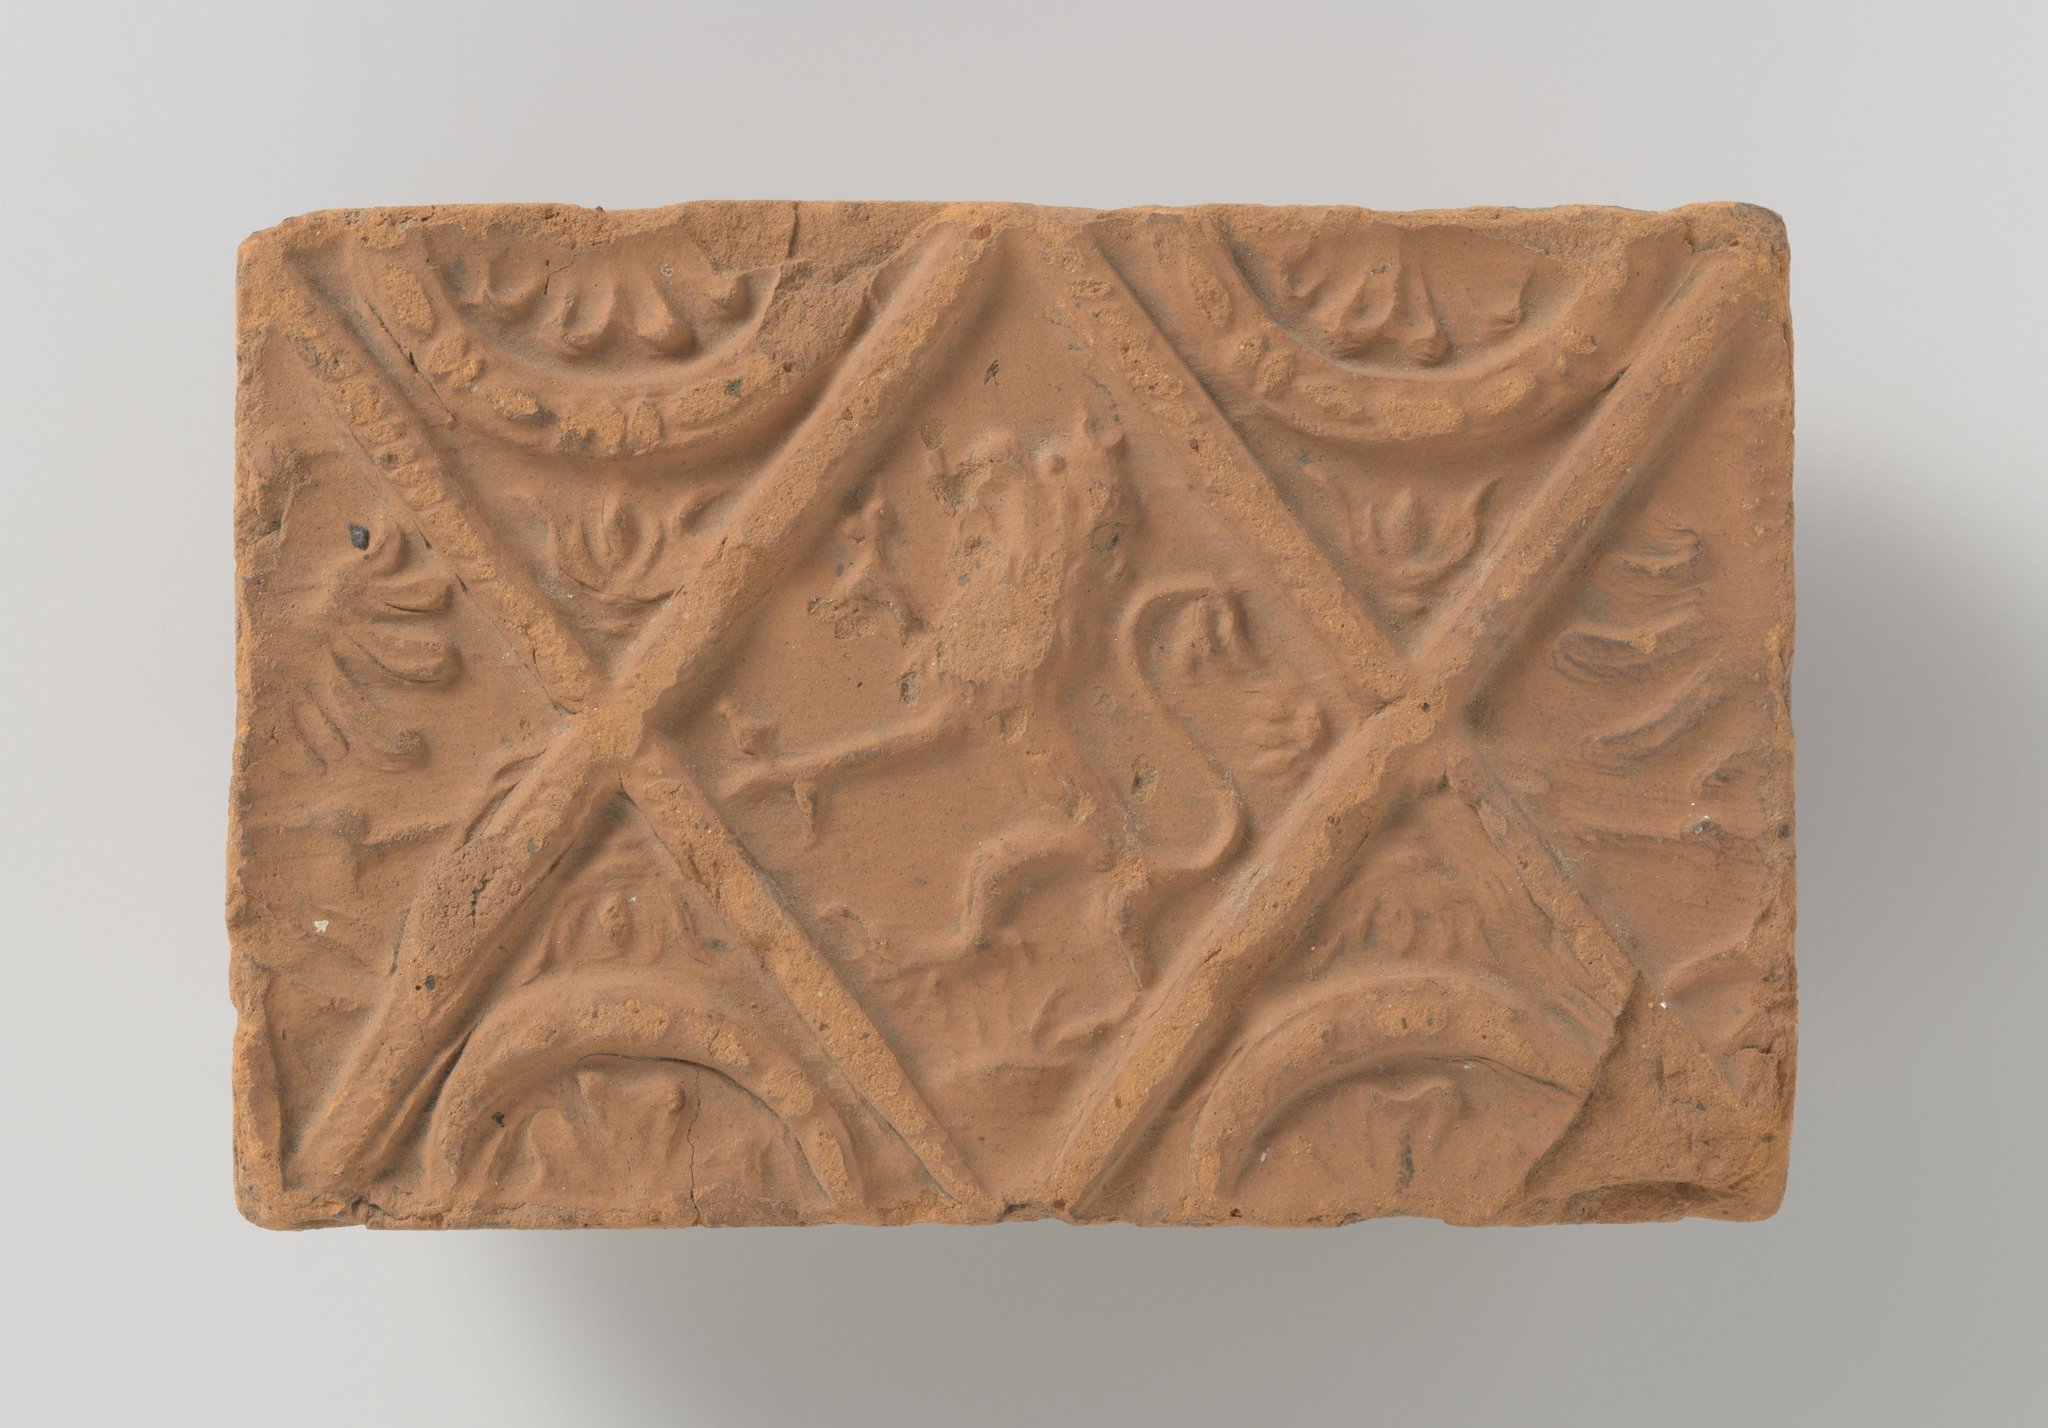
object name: architectural element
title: Haardsteen met leeuw in ruitvorm.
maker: Anonymous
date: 1400-1950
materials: earthenware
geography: netherlands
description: Een rode gebakken haardsteen met ruitversiering, waarin een leeuw. Gevonden nabij de Grebbe.